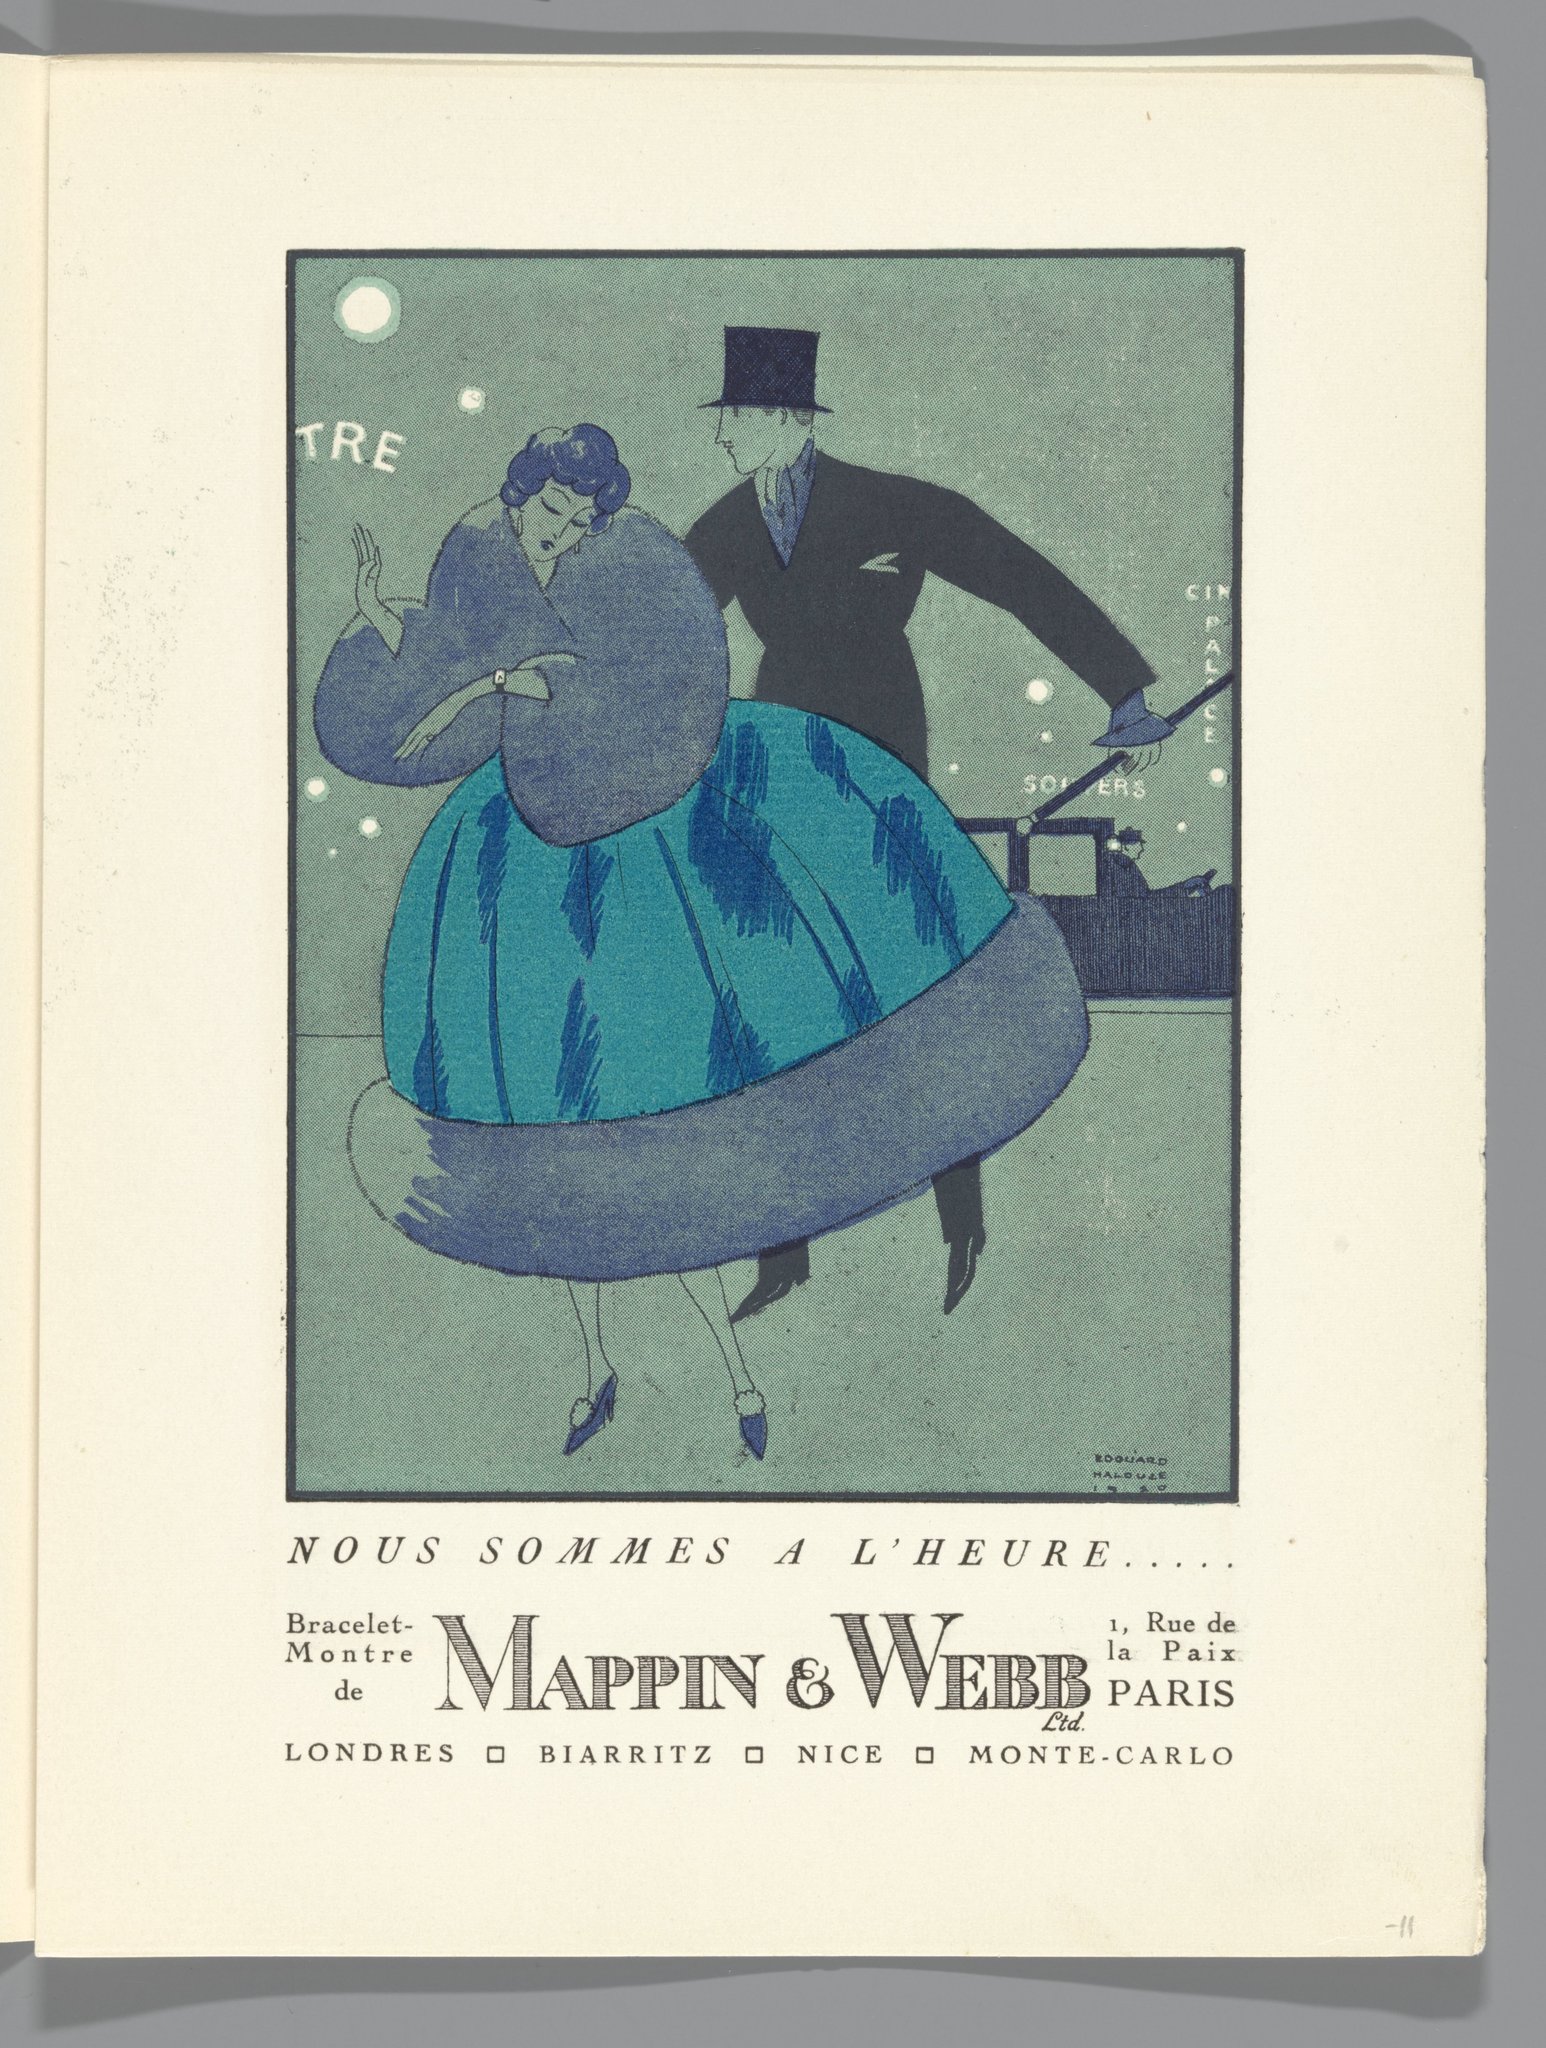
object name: fashion print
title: Gazette du Bon Ton, 1920 - No. 4, p. XXIX: advertentie Mappin & Webb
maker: lucien vogel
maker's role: publisher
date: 1920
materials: paper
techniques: hand coloring, lithograph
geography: new york city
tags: cape (+ women's clothes), fashion plates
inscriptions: date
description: Man en vrouw bij avond. De vrouw kijkt op haar horloge. Advertentie van de juwelier Mapin & Webb. p. XXIX in: Gazette du Bon Ton 1920, No. 4.